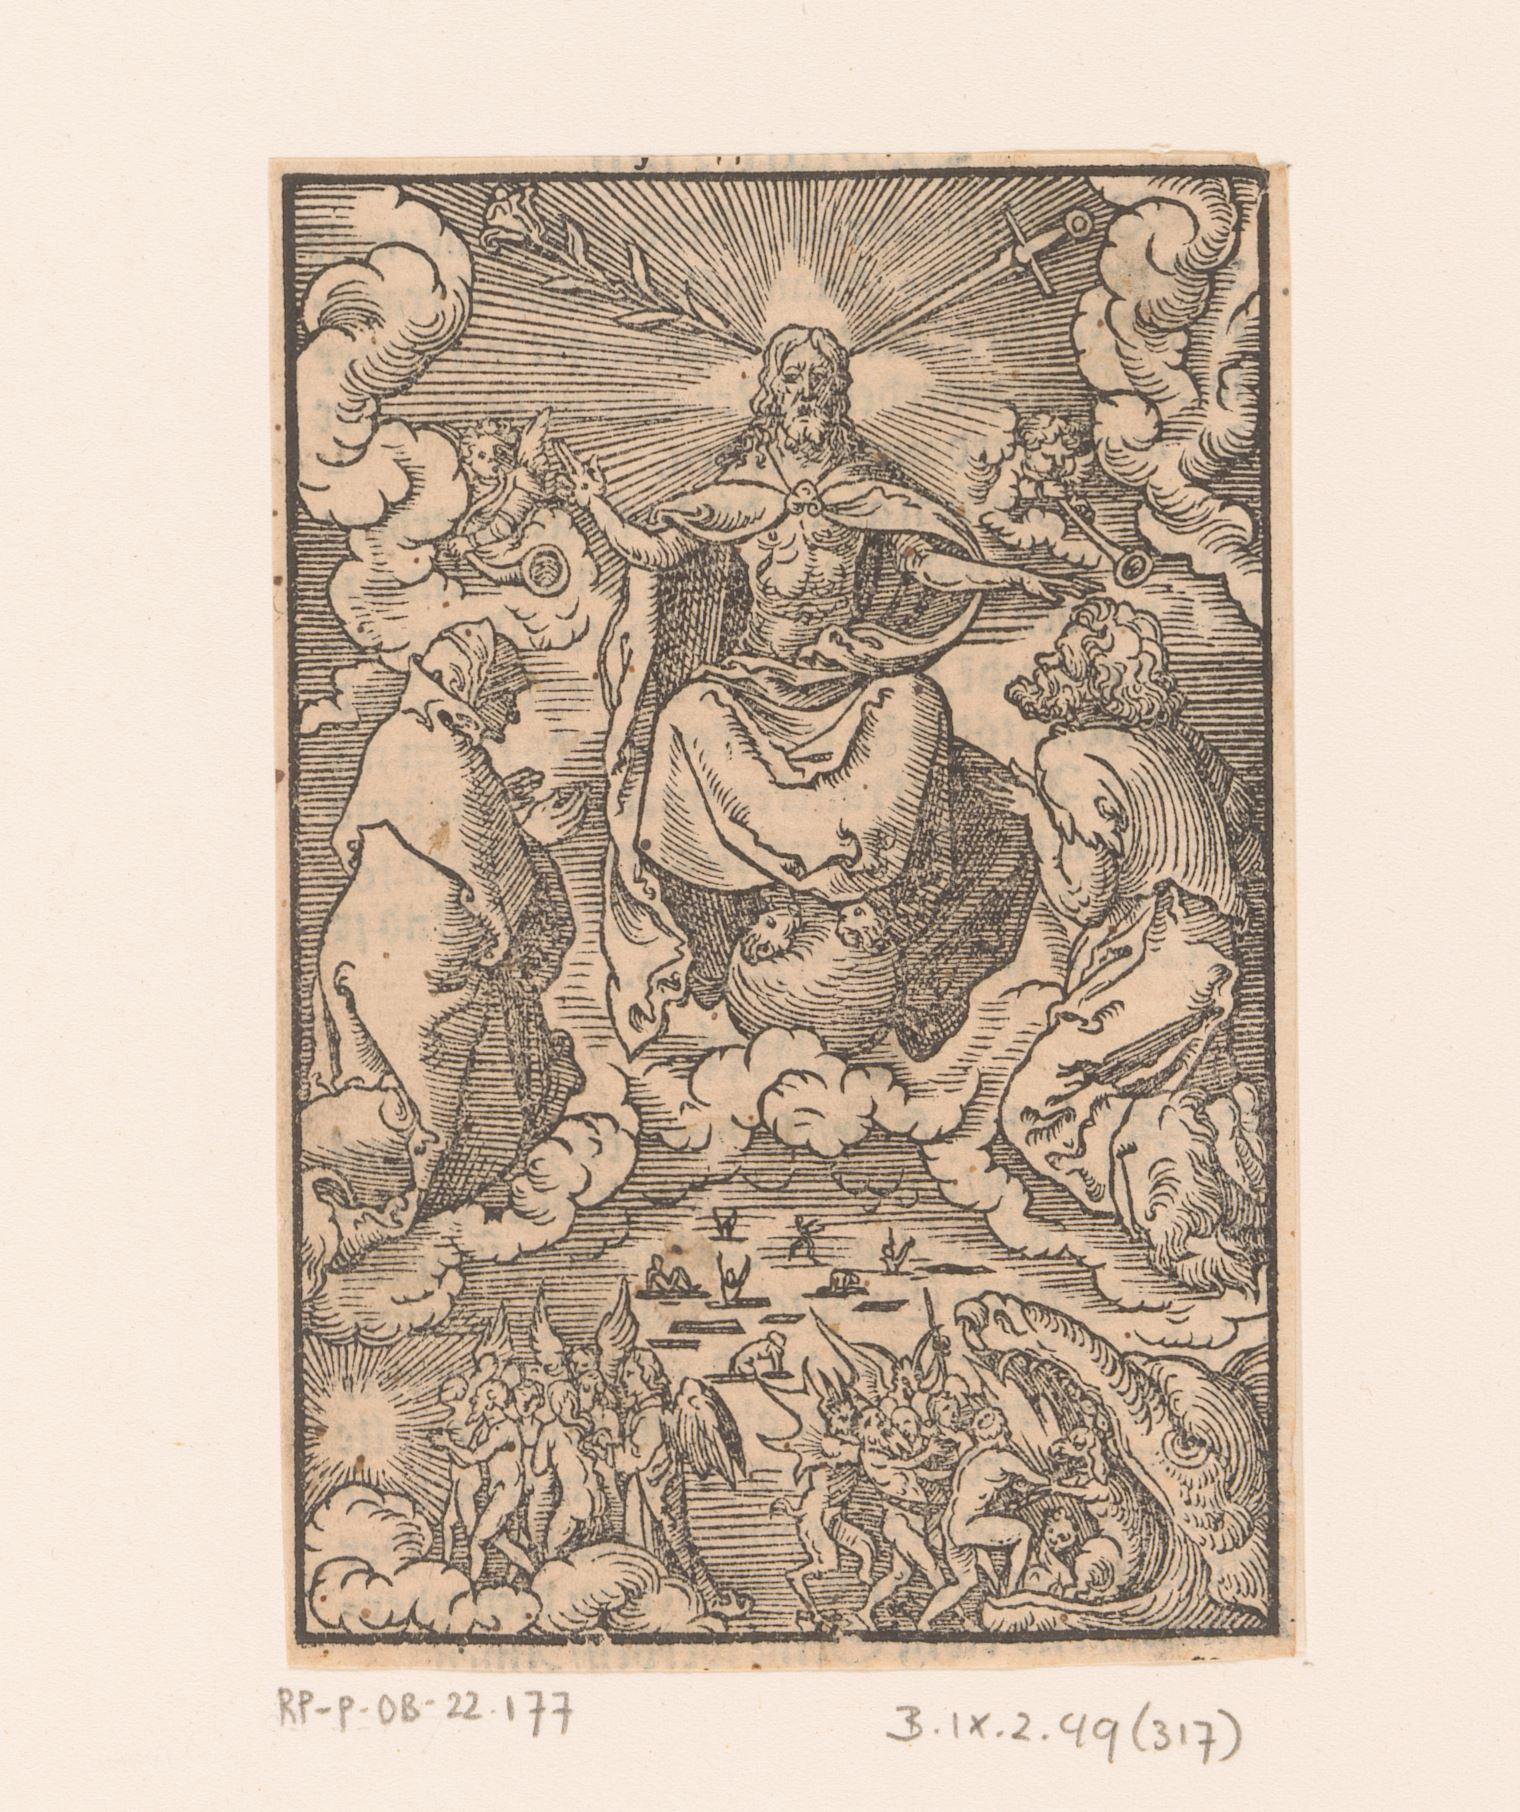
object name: book illustration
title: Laatste Oordeel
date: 1552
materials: paper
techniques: woodcut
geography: nuremberg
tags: comprehensive representation of last judgement: christ (with sword and lily), often surrounded by elders and sometimes accompanied by mary and john the baptist, appears in the sky with trumpeting angels (and sometimes angels holding the instruments of the passion); after the resurrection of the dead the blessed are led to heaven by angels, and the damned are dragged into hell by devils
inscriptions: number: ‘181’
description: Gebruikt voor verschillende publicaties die werden gedrukt door Valentin Geißler tussen 1552 en 1560 te Neurenberg.